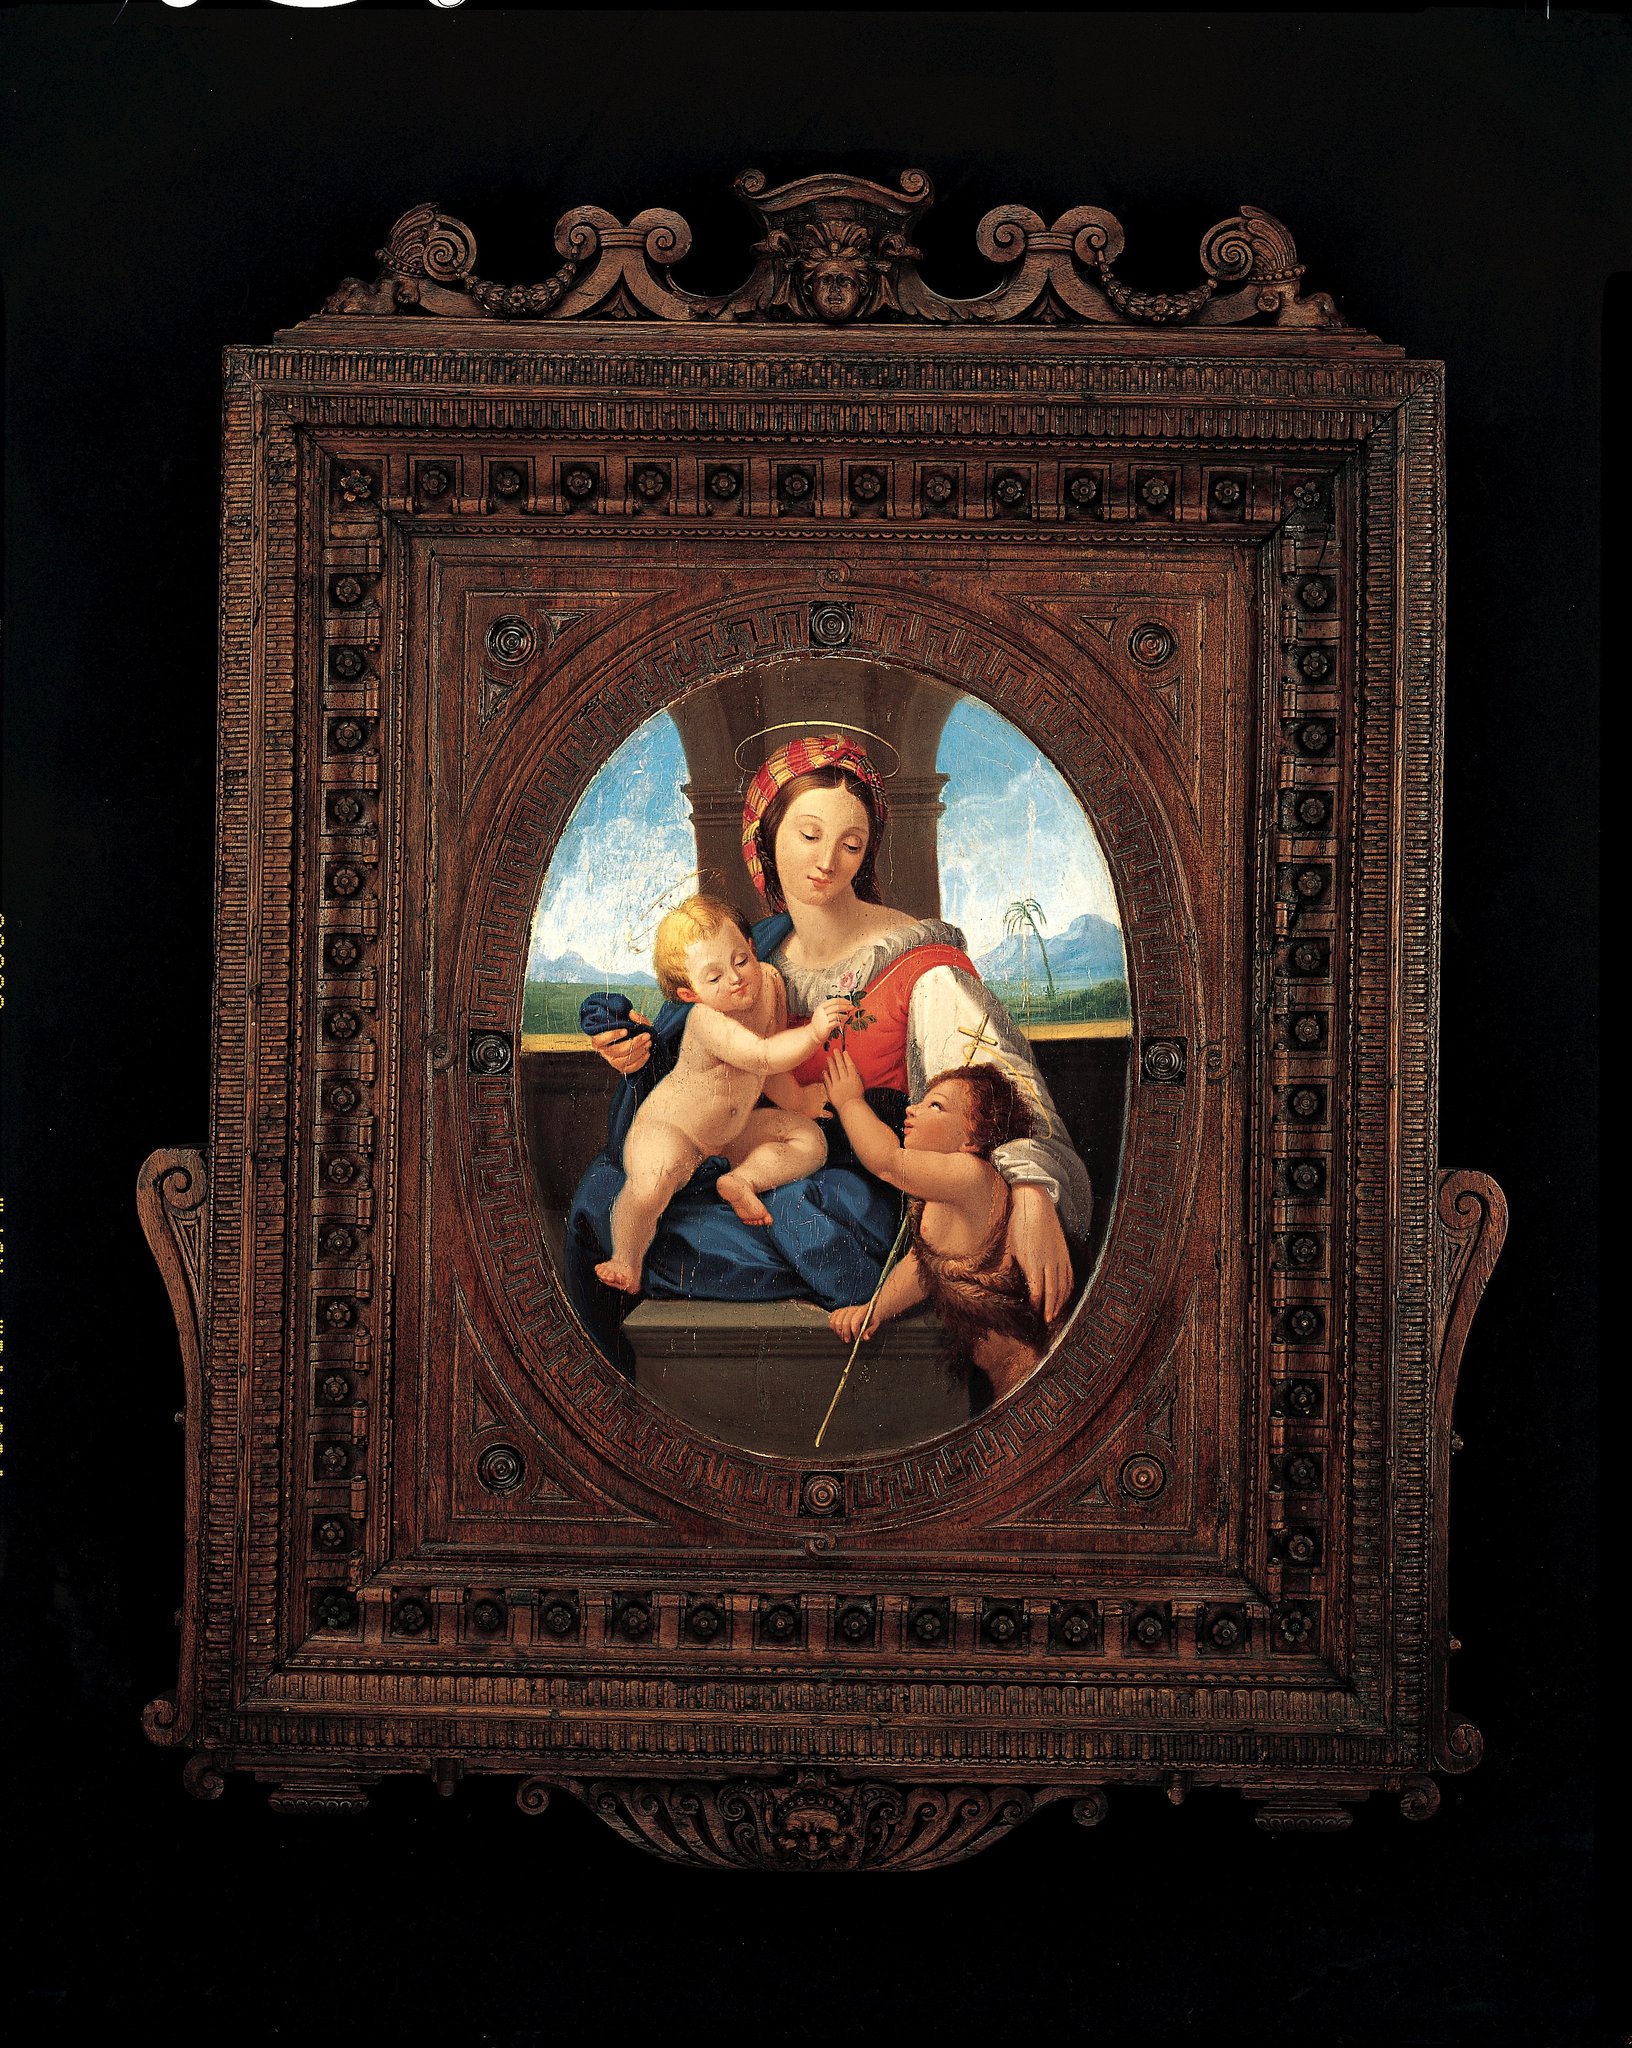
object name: frame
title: Mirror frame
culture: italian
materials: wood